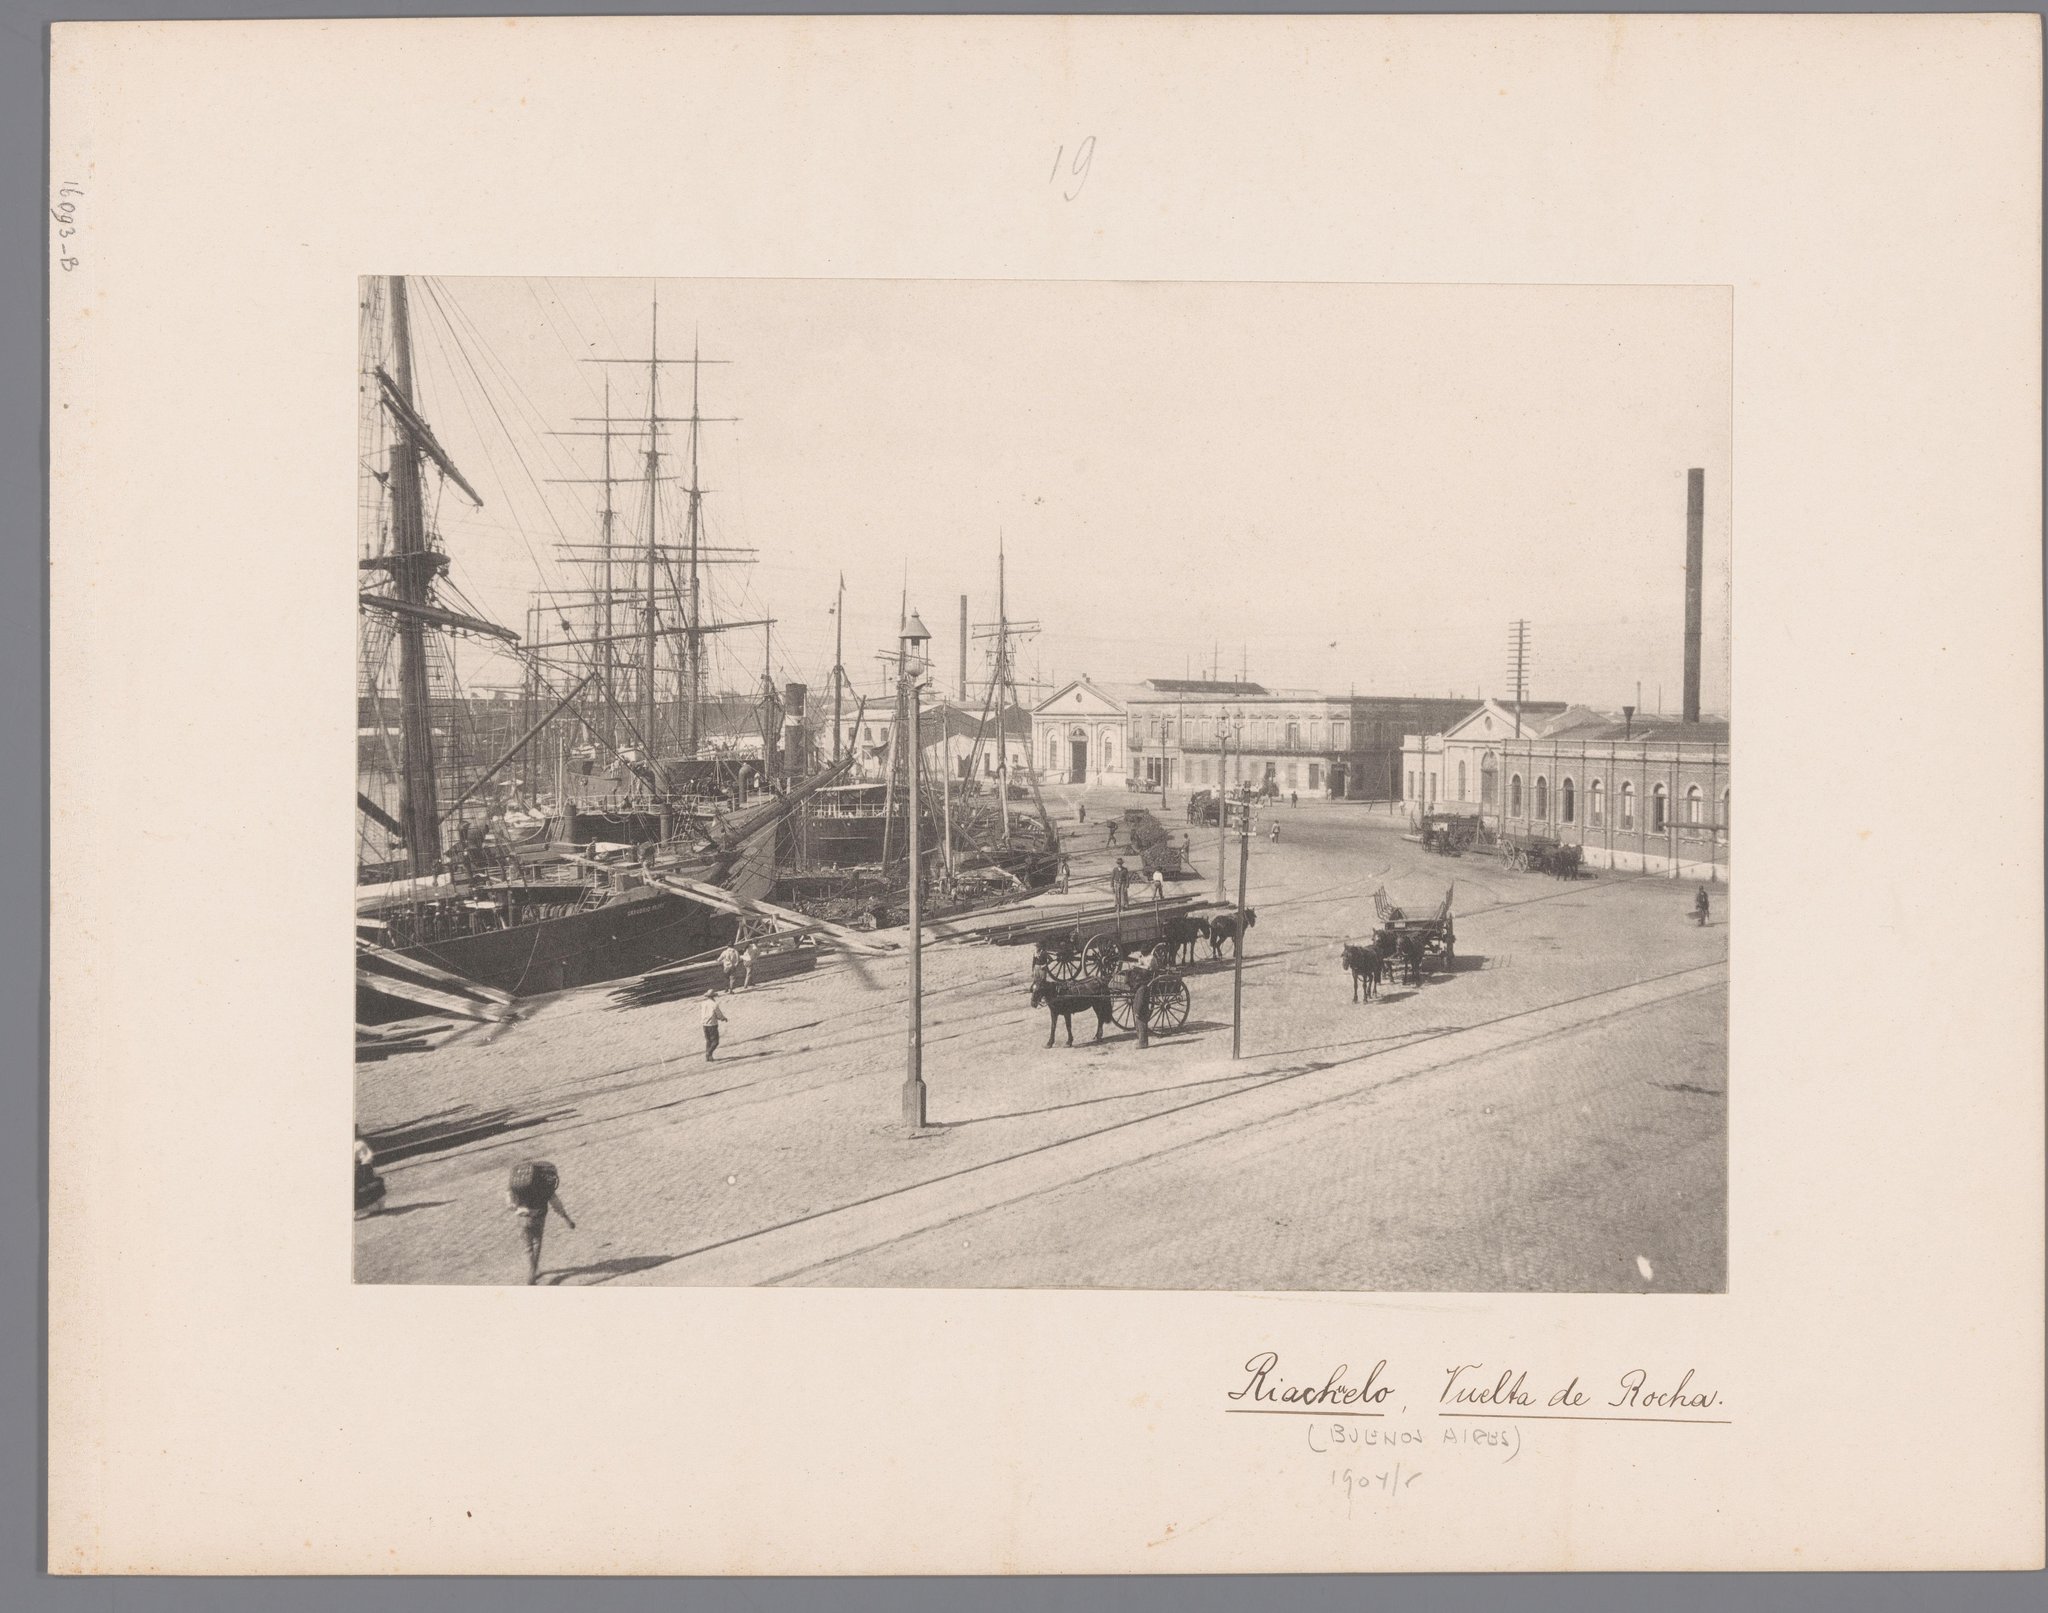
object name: photomechanical print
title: Gezicht op een haven aan de Riachuelo in Buenos Aires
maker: Anonymous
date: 1904-1905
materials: cardboard, paper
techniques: photograph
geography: buenos aires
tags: harbour